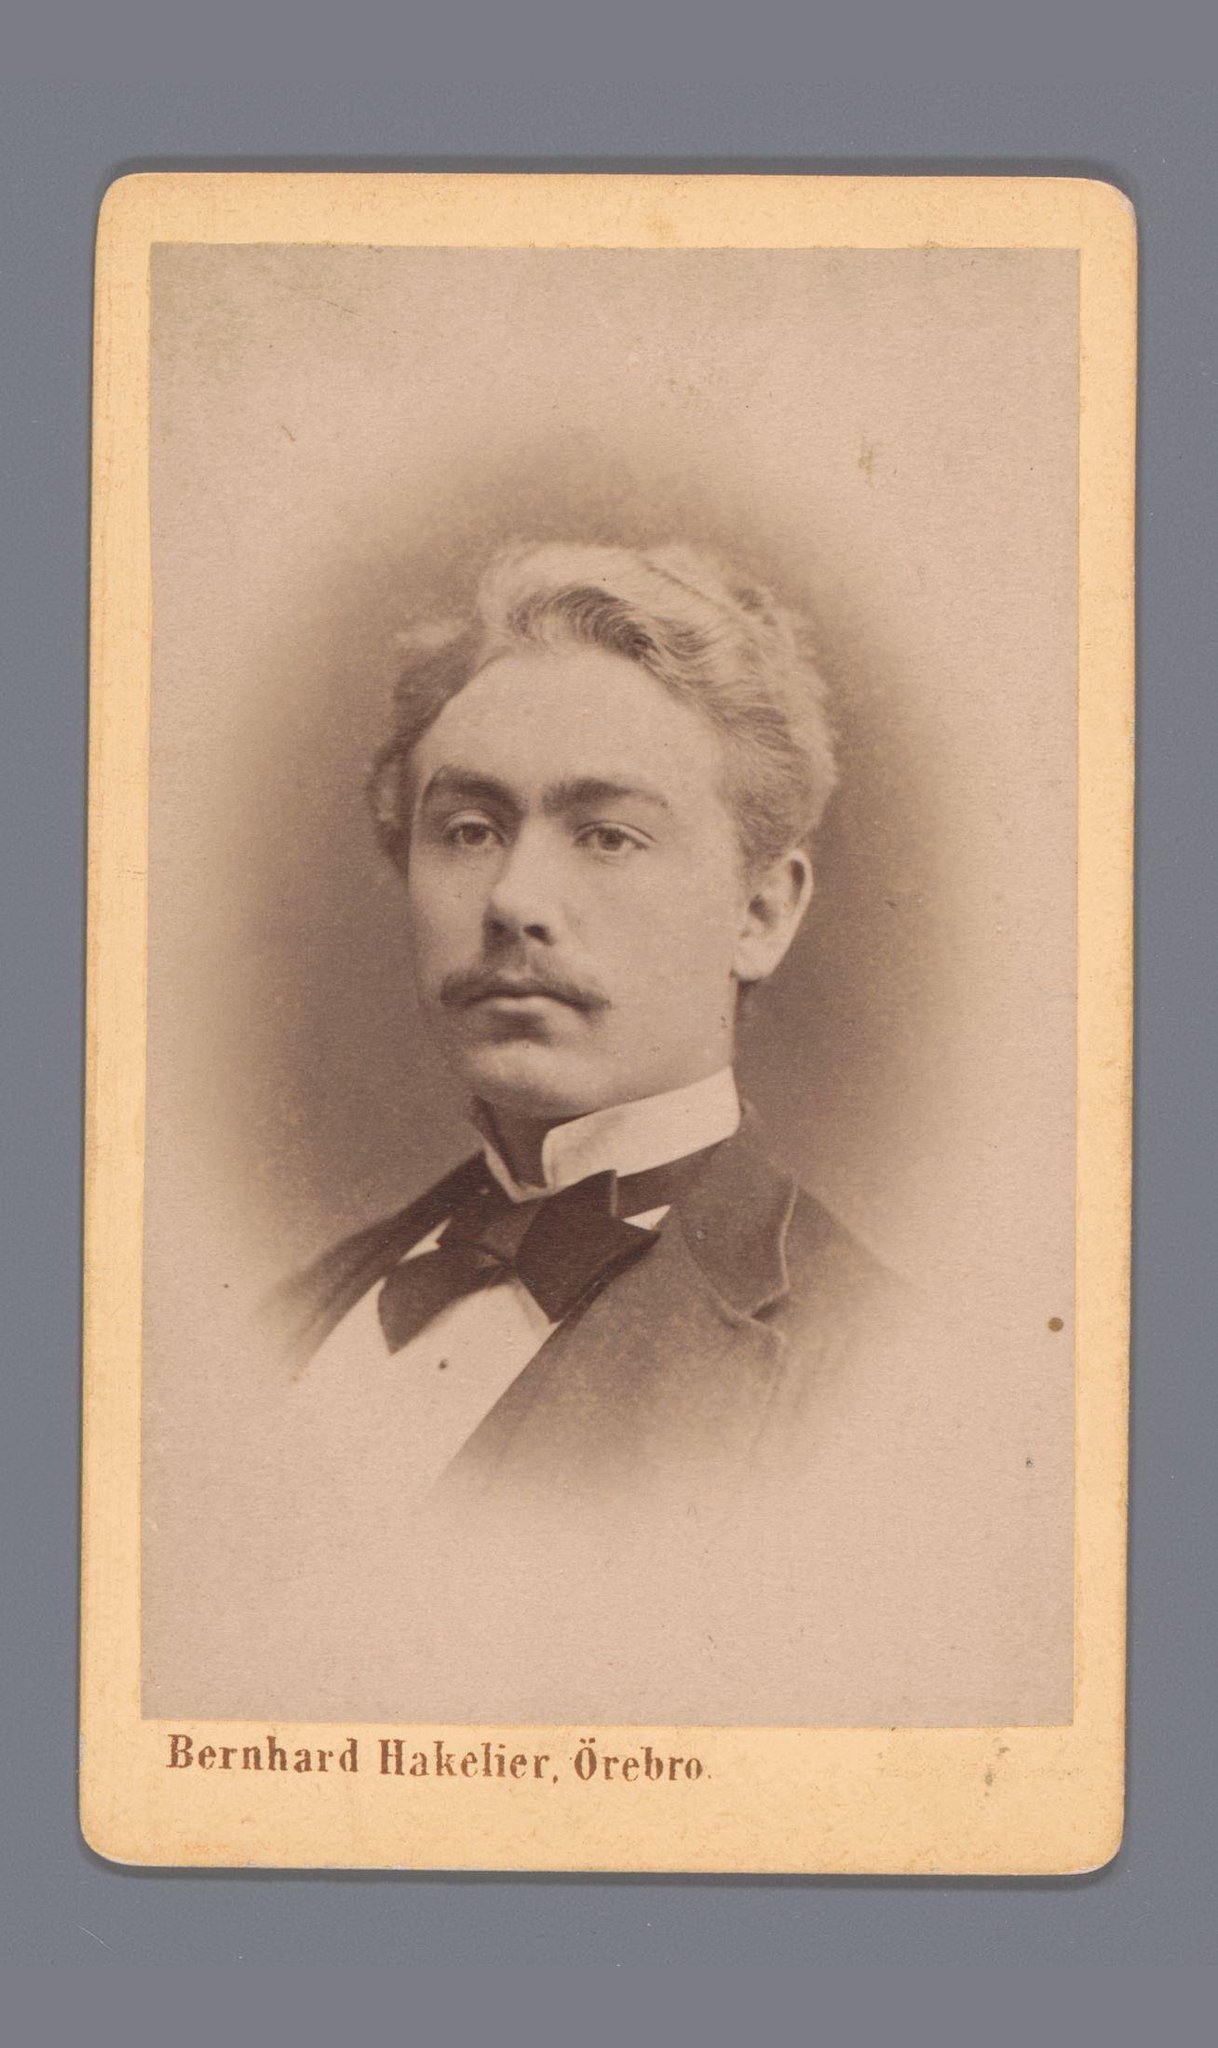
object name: carte de visite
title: Portret van een onbekende jongeman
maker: bernhard hakelier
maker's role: fotograaf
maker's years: 1848-1910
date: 1871-1885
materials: cardboard, paper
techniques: albumen print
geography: orebro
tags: historical persons, youth, adolescent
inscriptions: inscription: ‘FOTOGRAFI/ af/ Bernhard Hakelier./ ÖREBRO/ 21. Köpmangatan 21./ Större antal af samma sort kan erhållas om Requisi-/tion insändes till Ateliern./ A larger number of the same sort can be had on/ application to Mr Hakelier 21 Mechant street Örebro.’